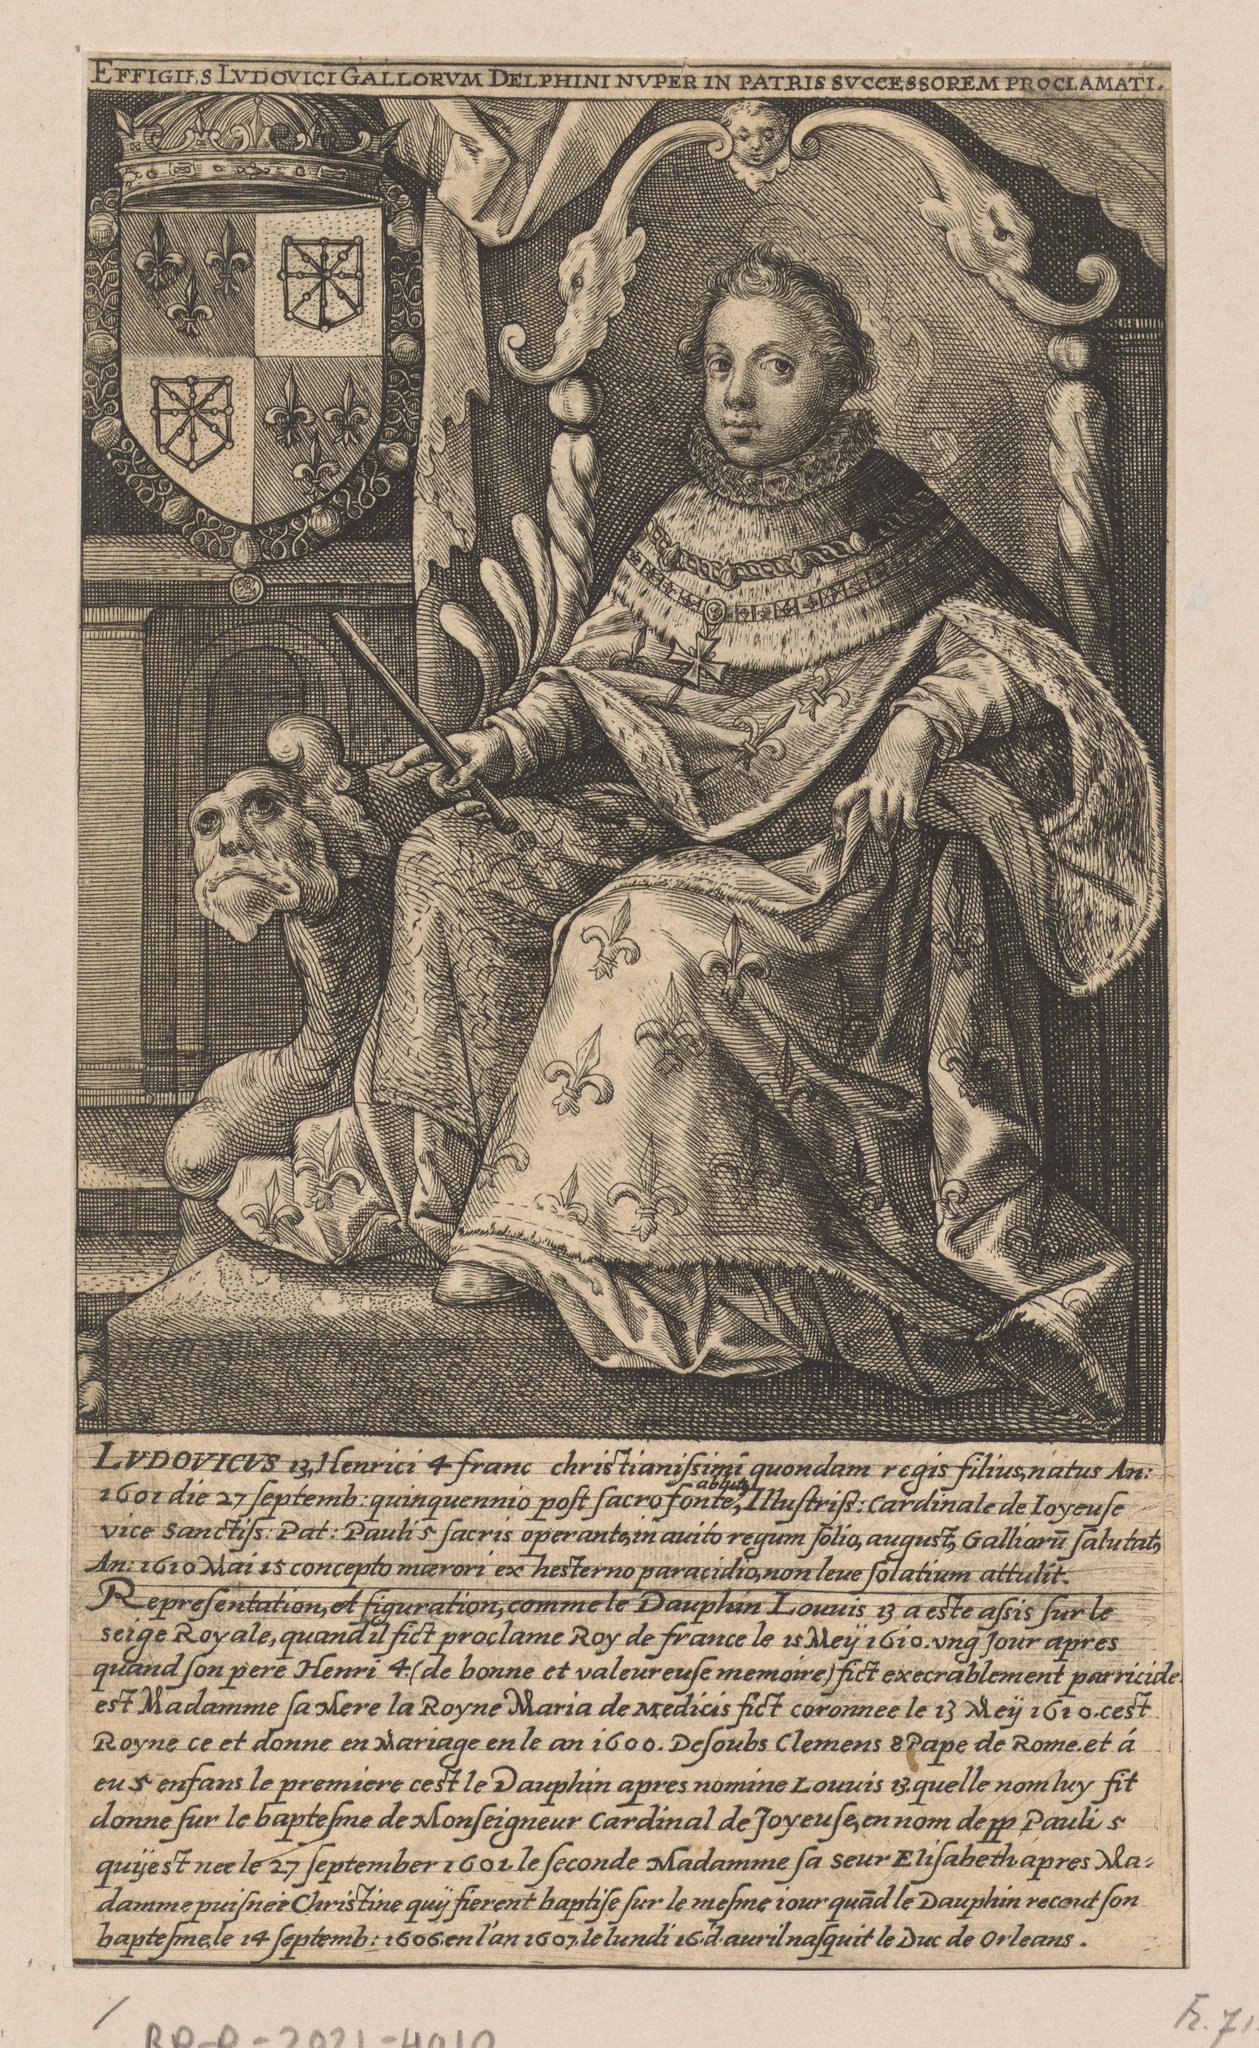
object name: print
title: Portret van Lodewijk XIII van Frankrijk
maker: crispijn van de passe (i)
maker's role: draughtsman, print maker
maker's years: 1564-1637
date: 1610-1637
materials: paper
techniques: engraving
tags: lodewijk xiii (koning van frankrijk), historical persons, throne, knighthood order of the holy spirit, king, armorial bearing, heraldry, royal mantle (symbol of sovereignty)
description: Portret van Lodewijk XIII, koning van Frankrijk. Hij zit op een troon en draagt een Ordeketting van de Orde van de Heilige Geest. In de marge een vierregelig onderschrift in het Latijn en een tienregelig onderschrift in het Frans over het leven van de prins tot aan het moment dat hij op 15 mei 1610 tot koning werd benoemd. Pendant van een portret van Maria de' Medici.